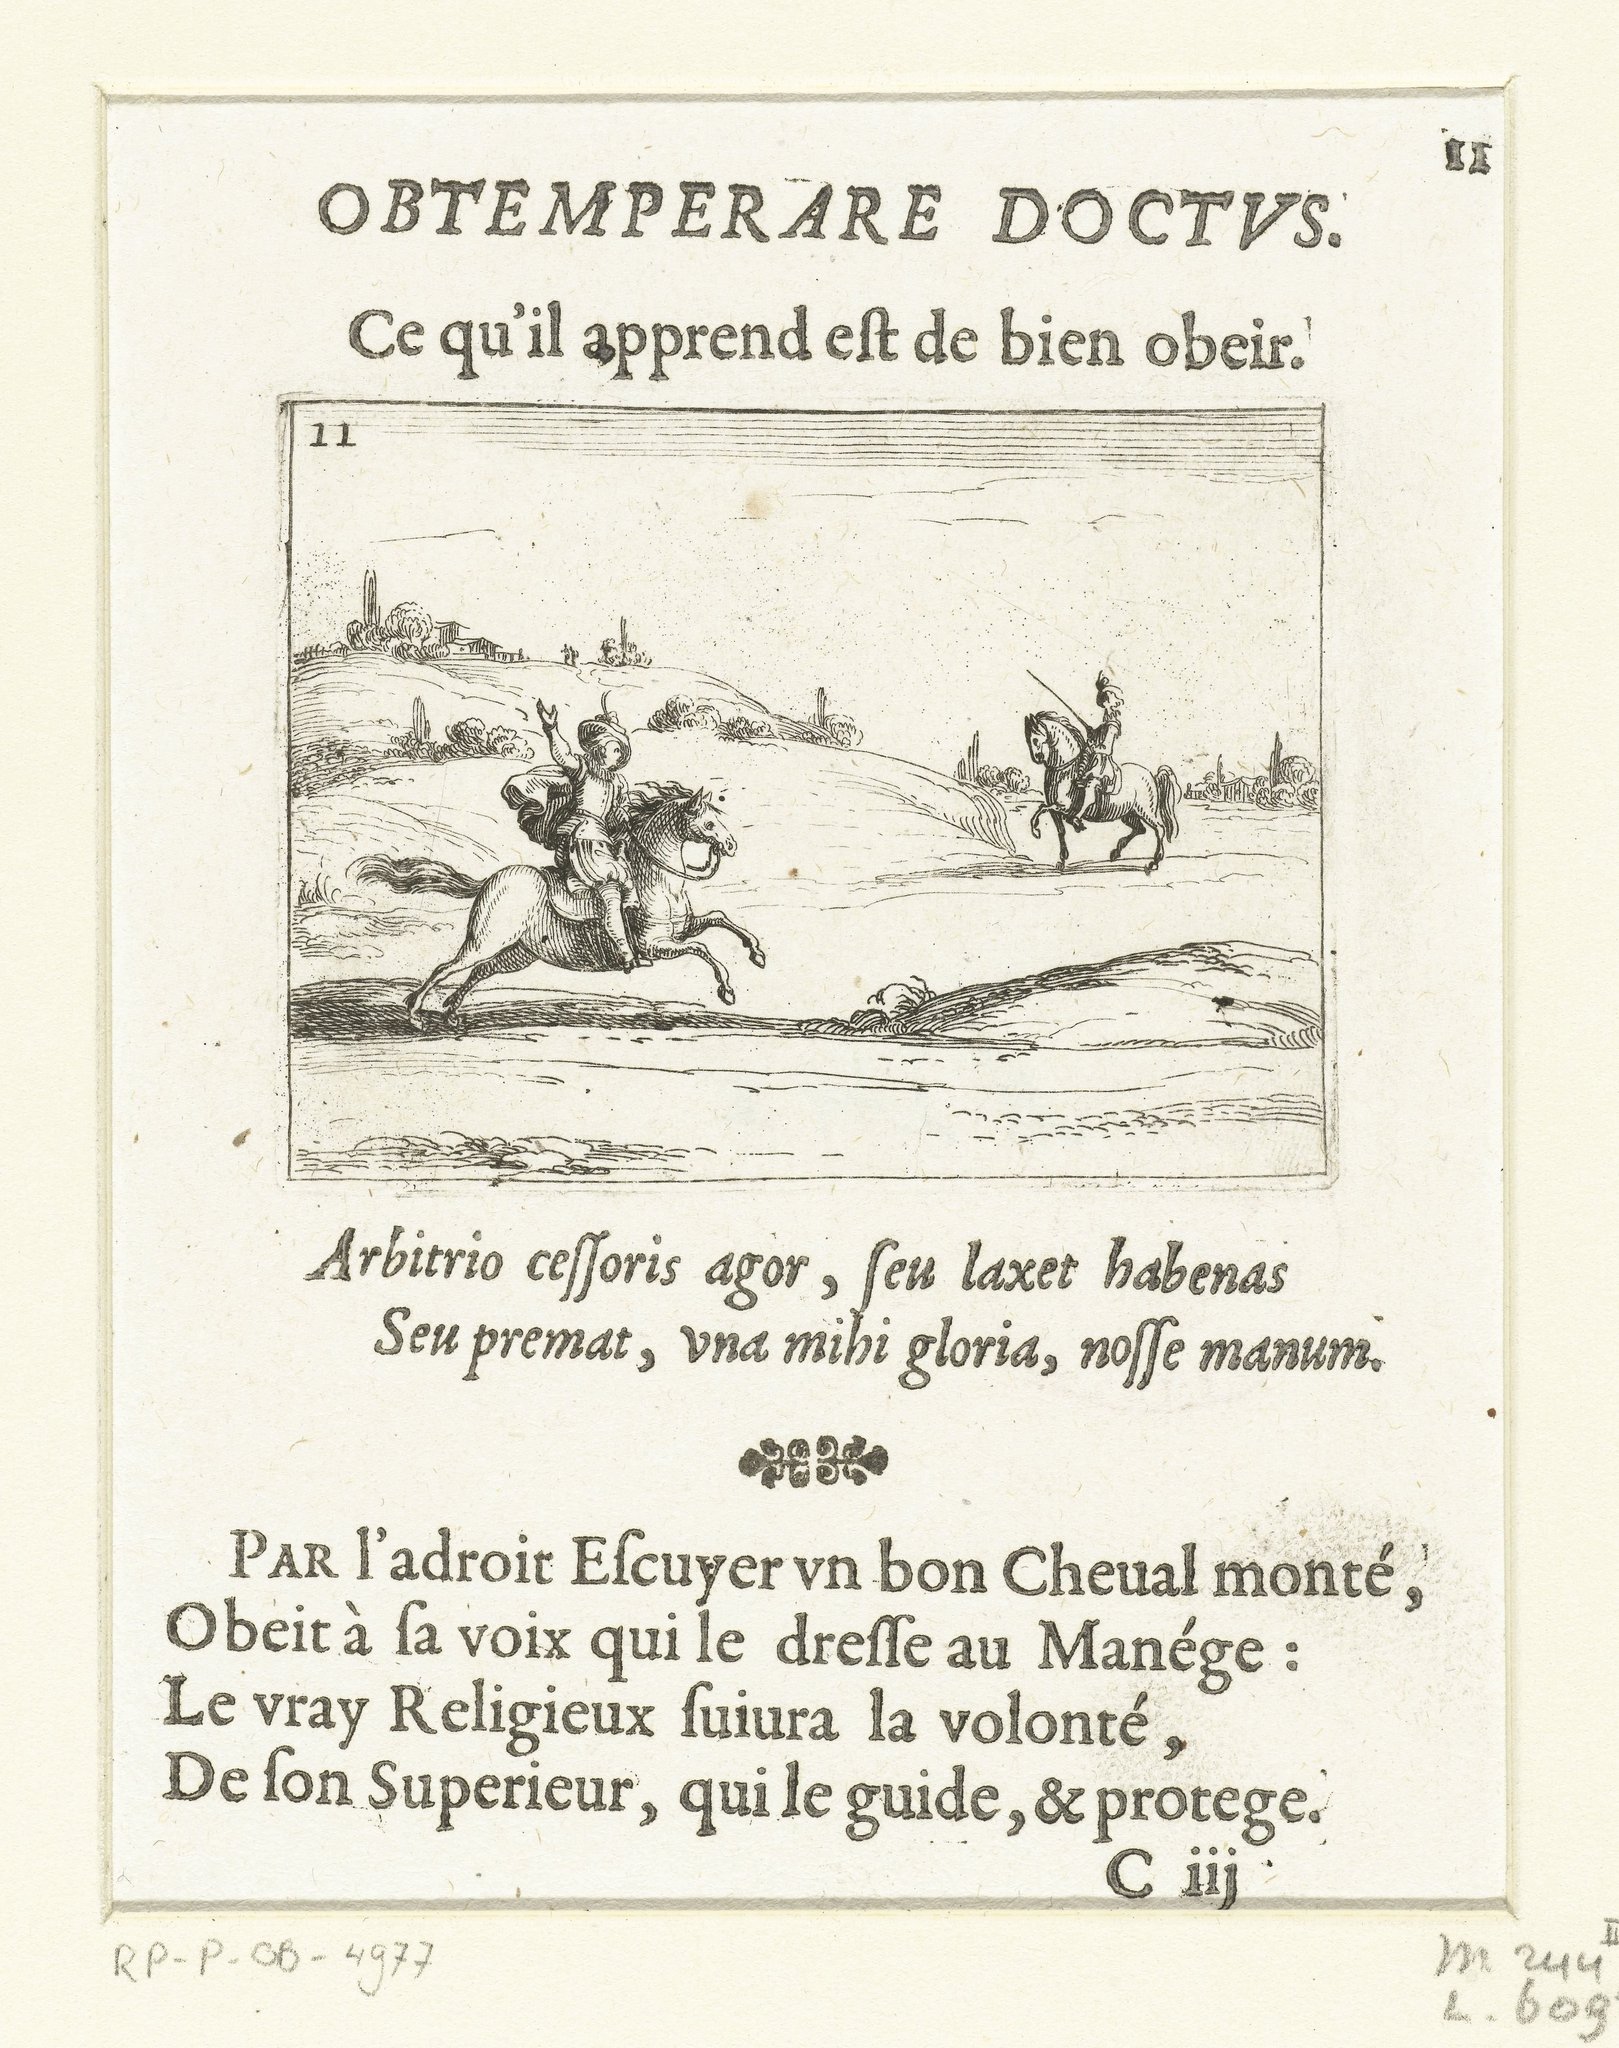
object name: print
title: Twee ruiters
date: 1621-1635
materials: paper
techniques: etching, letterpress printing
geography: paris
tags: riding a horse, ass, or mule; rider, horseman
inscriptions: collector's mark: Lugt 240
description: Voorstelling van een ruiter op een paard in galop (links) en een tweede ruiter op een paard dat rustig loopt (rechts). Boven en onder deze prent Latijnse en Franse teksten in boekdruk. Dit blad is onderdeel van de embleemserie 'Kloosterleven in emblemen'. De tweede staat van deze serie behelst naast een geïllustreerde titelpagina en 26 emblemen nog een titelpagina en een blad met opdracht, beide in boekdruk zonder afbeelding.